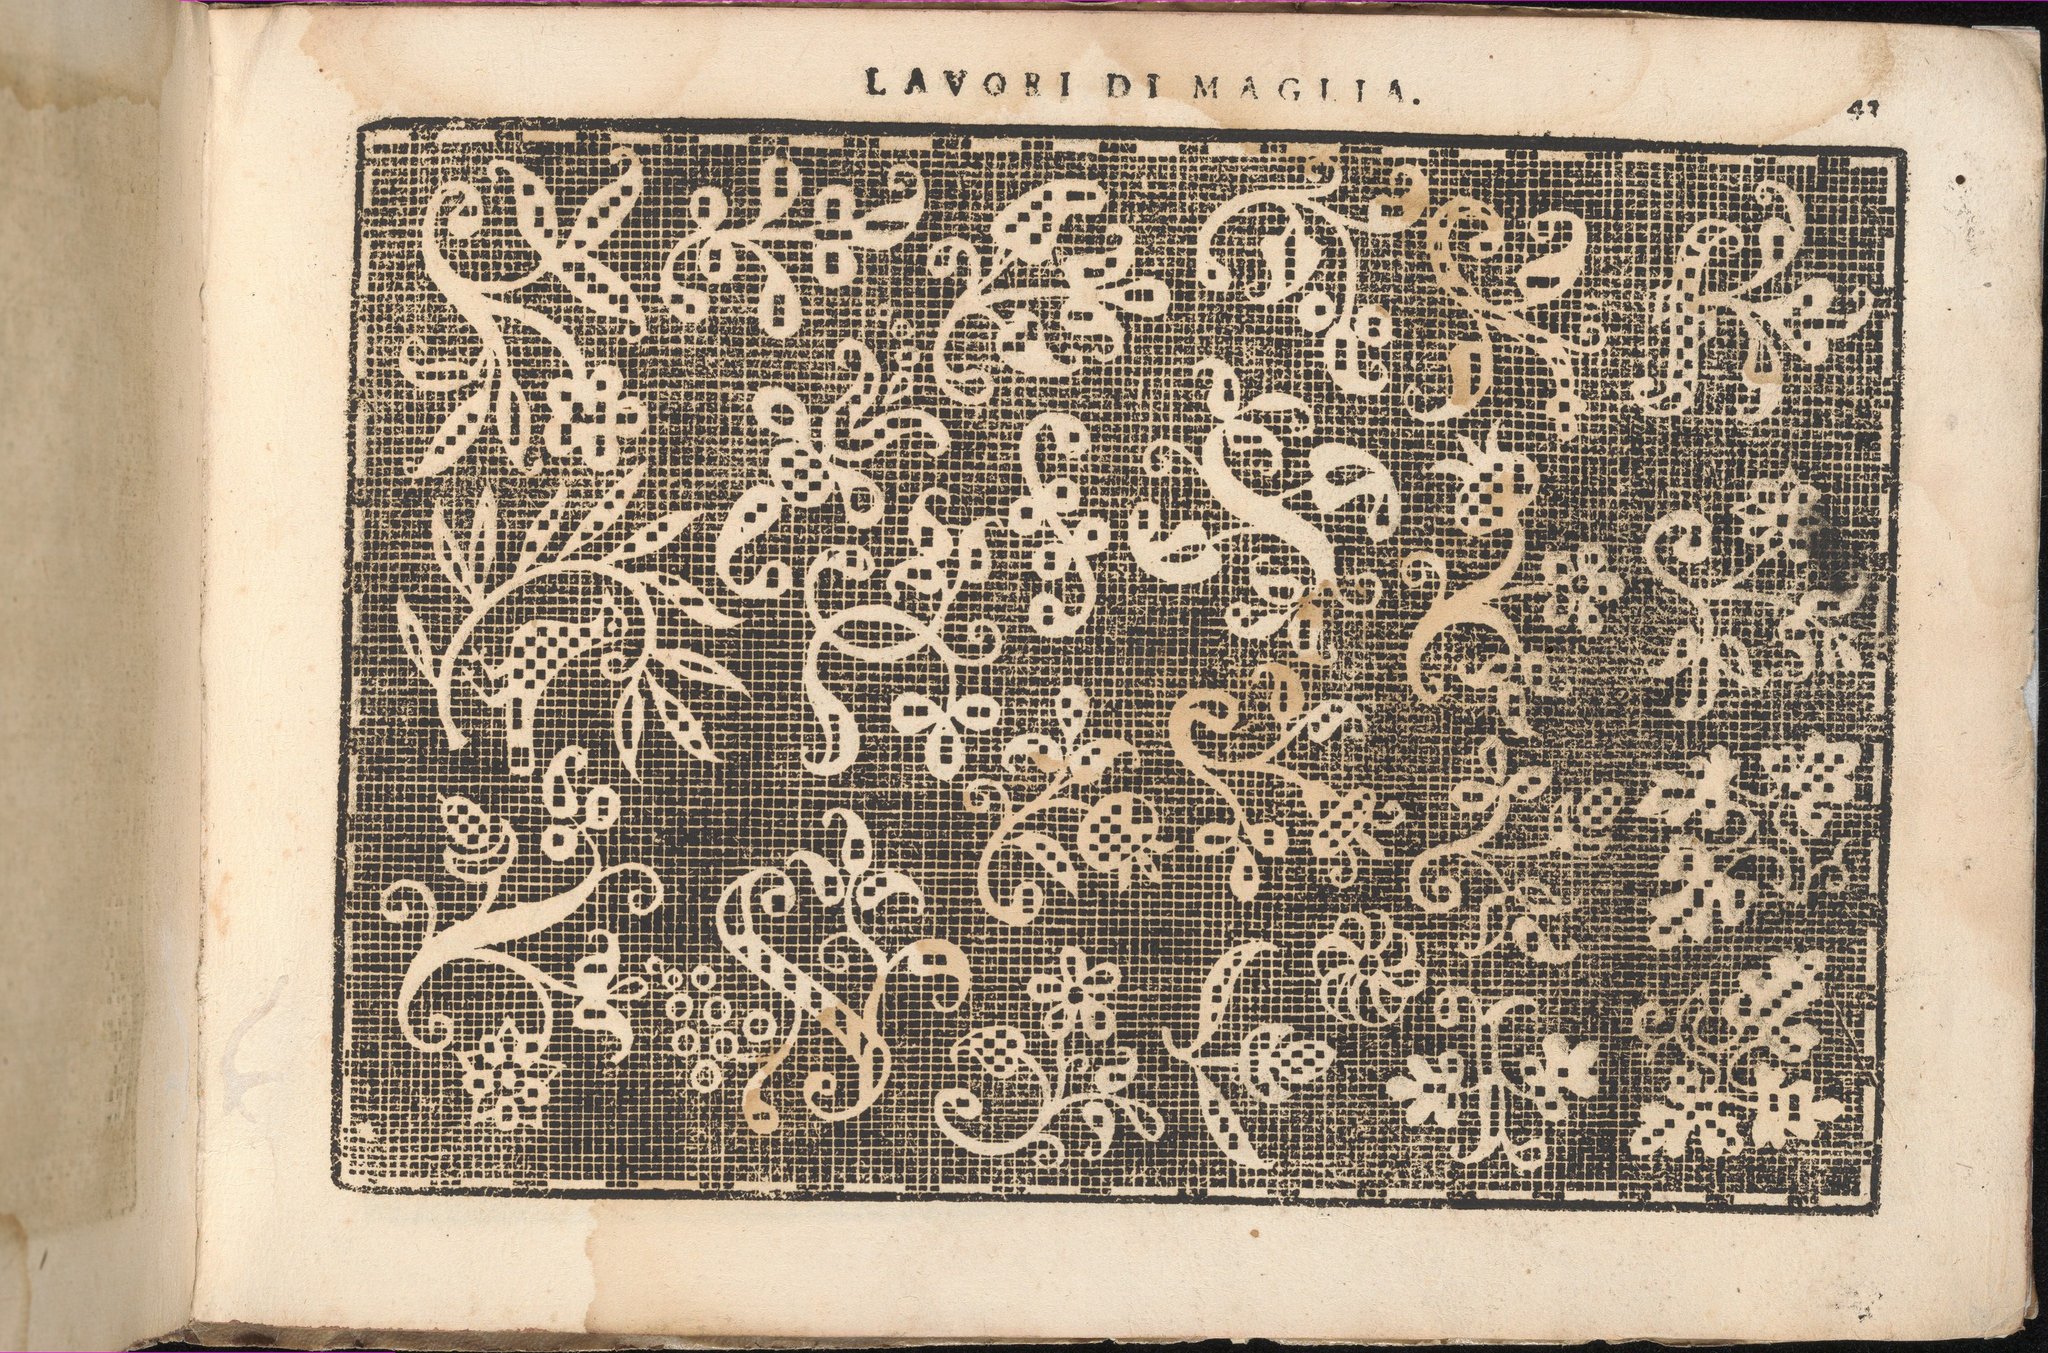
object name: book print ornament architecture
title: Teatro delle Nobili et Virtuose Donne..., page 43 (recto)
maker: isabella catanea parasole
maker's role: author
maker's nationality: italian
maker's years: 1565-1625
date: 1616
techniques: engraving, woodcut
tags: ornament